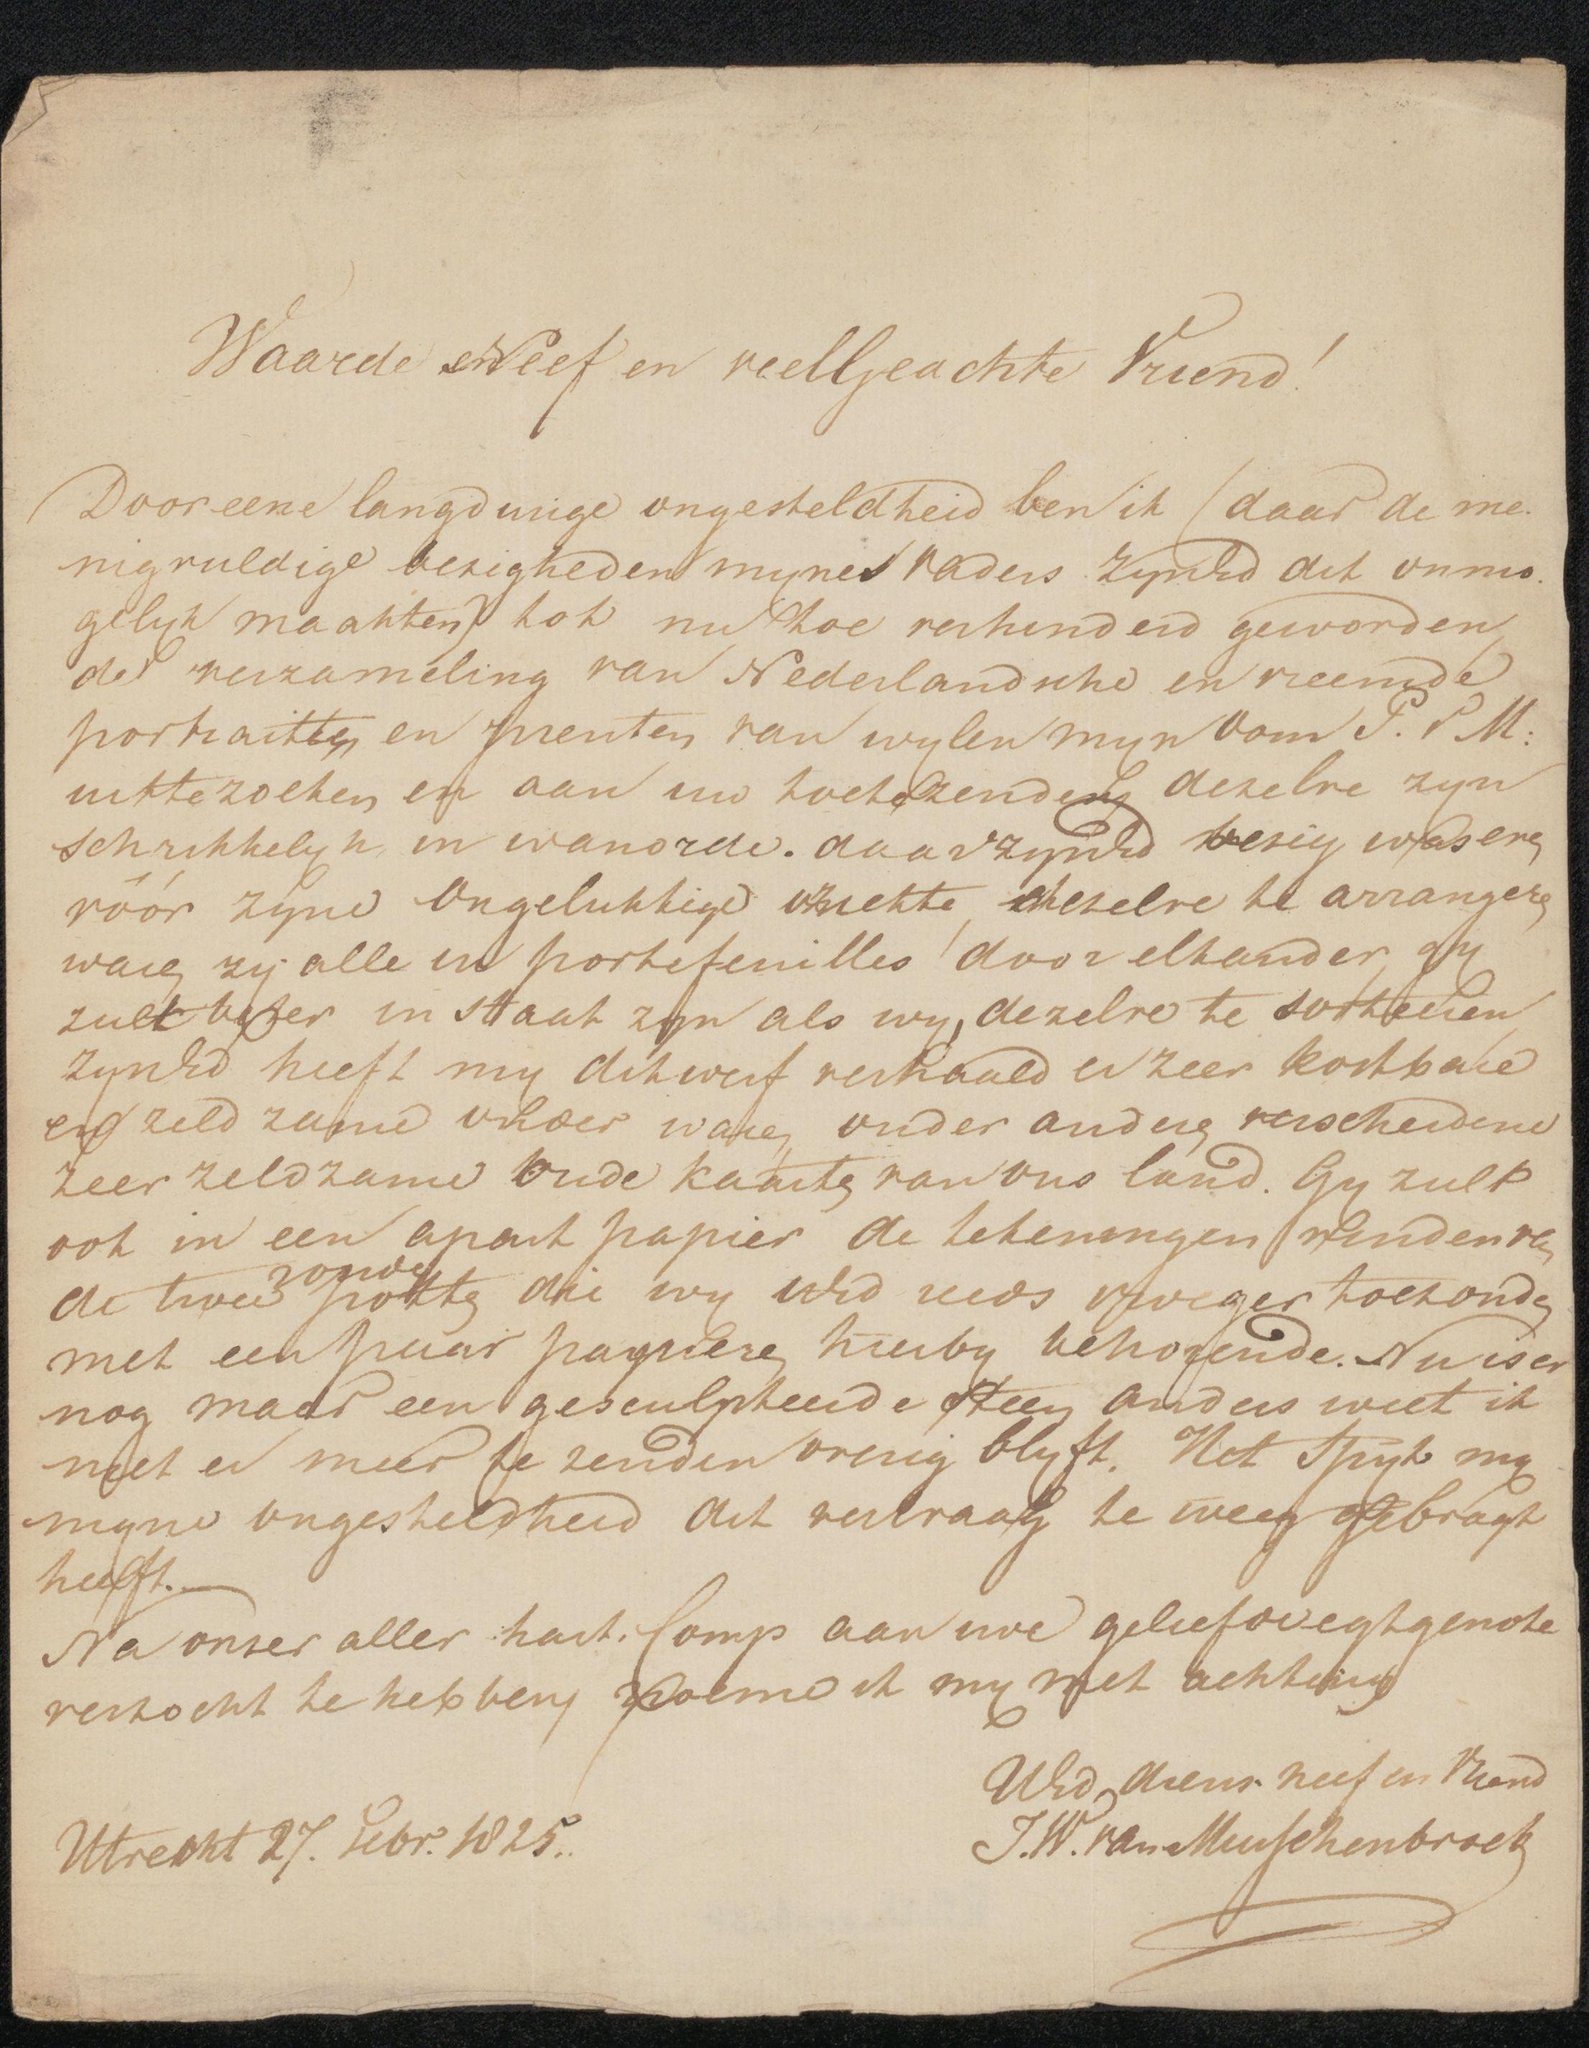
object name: letter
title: Brief aan Johannes Tiberius Bodel Nijenhuis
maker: jan willem van musschenbroek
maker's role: griffier, schrijver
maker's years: 1802-1878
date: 1825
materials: ink, paper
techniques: pen, writing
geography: utrecht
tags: amsterdam, leiden, publisher, johannes tiberius bodel nijenhuis, physicist, drawing, the graphic arts, anonymous historical person portrayed, diseases, art collecting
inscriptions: watermark, seal